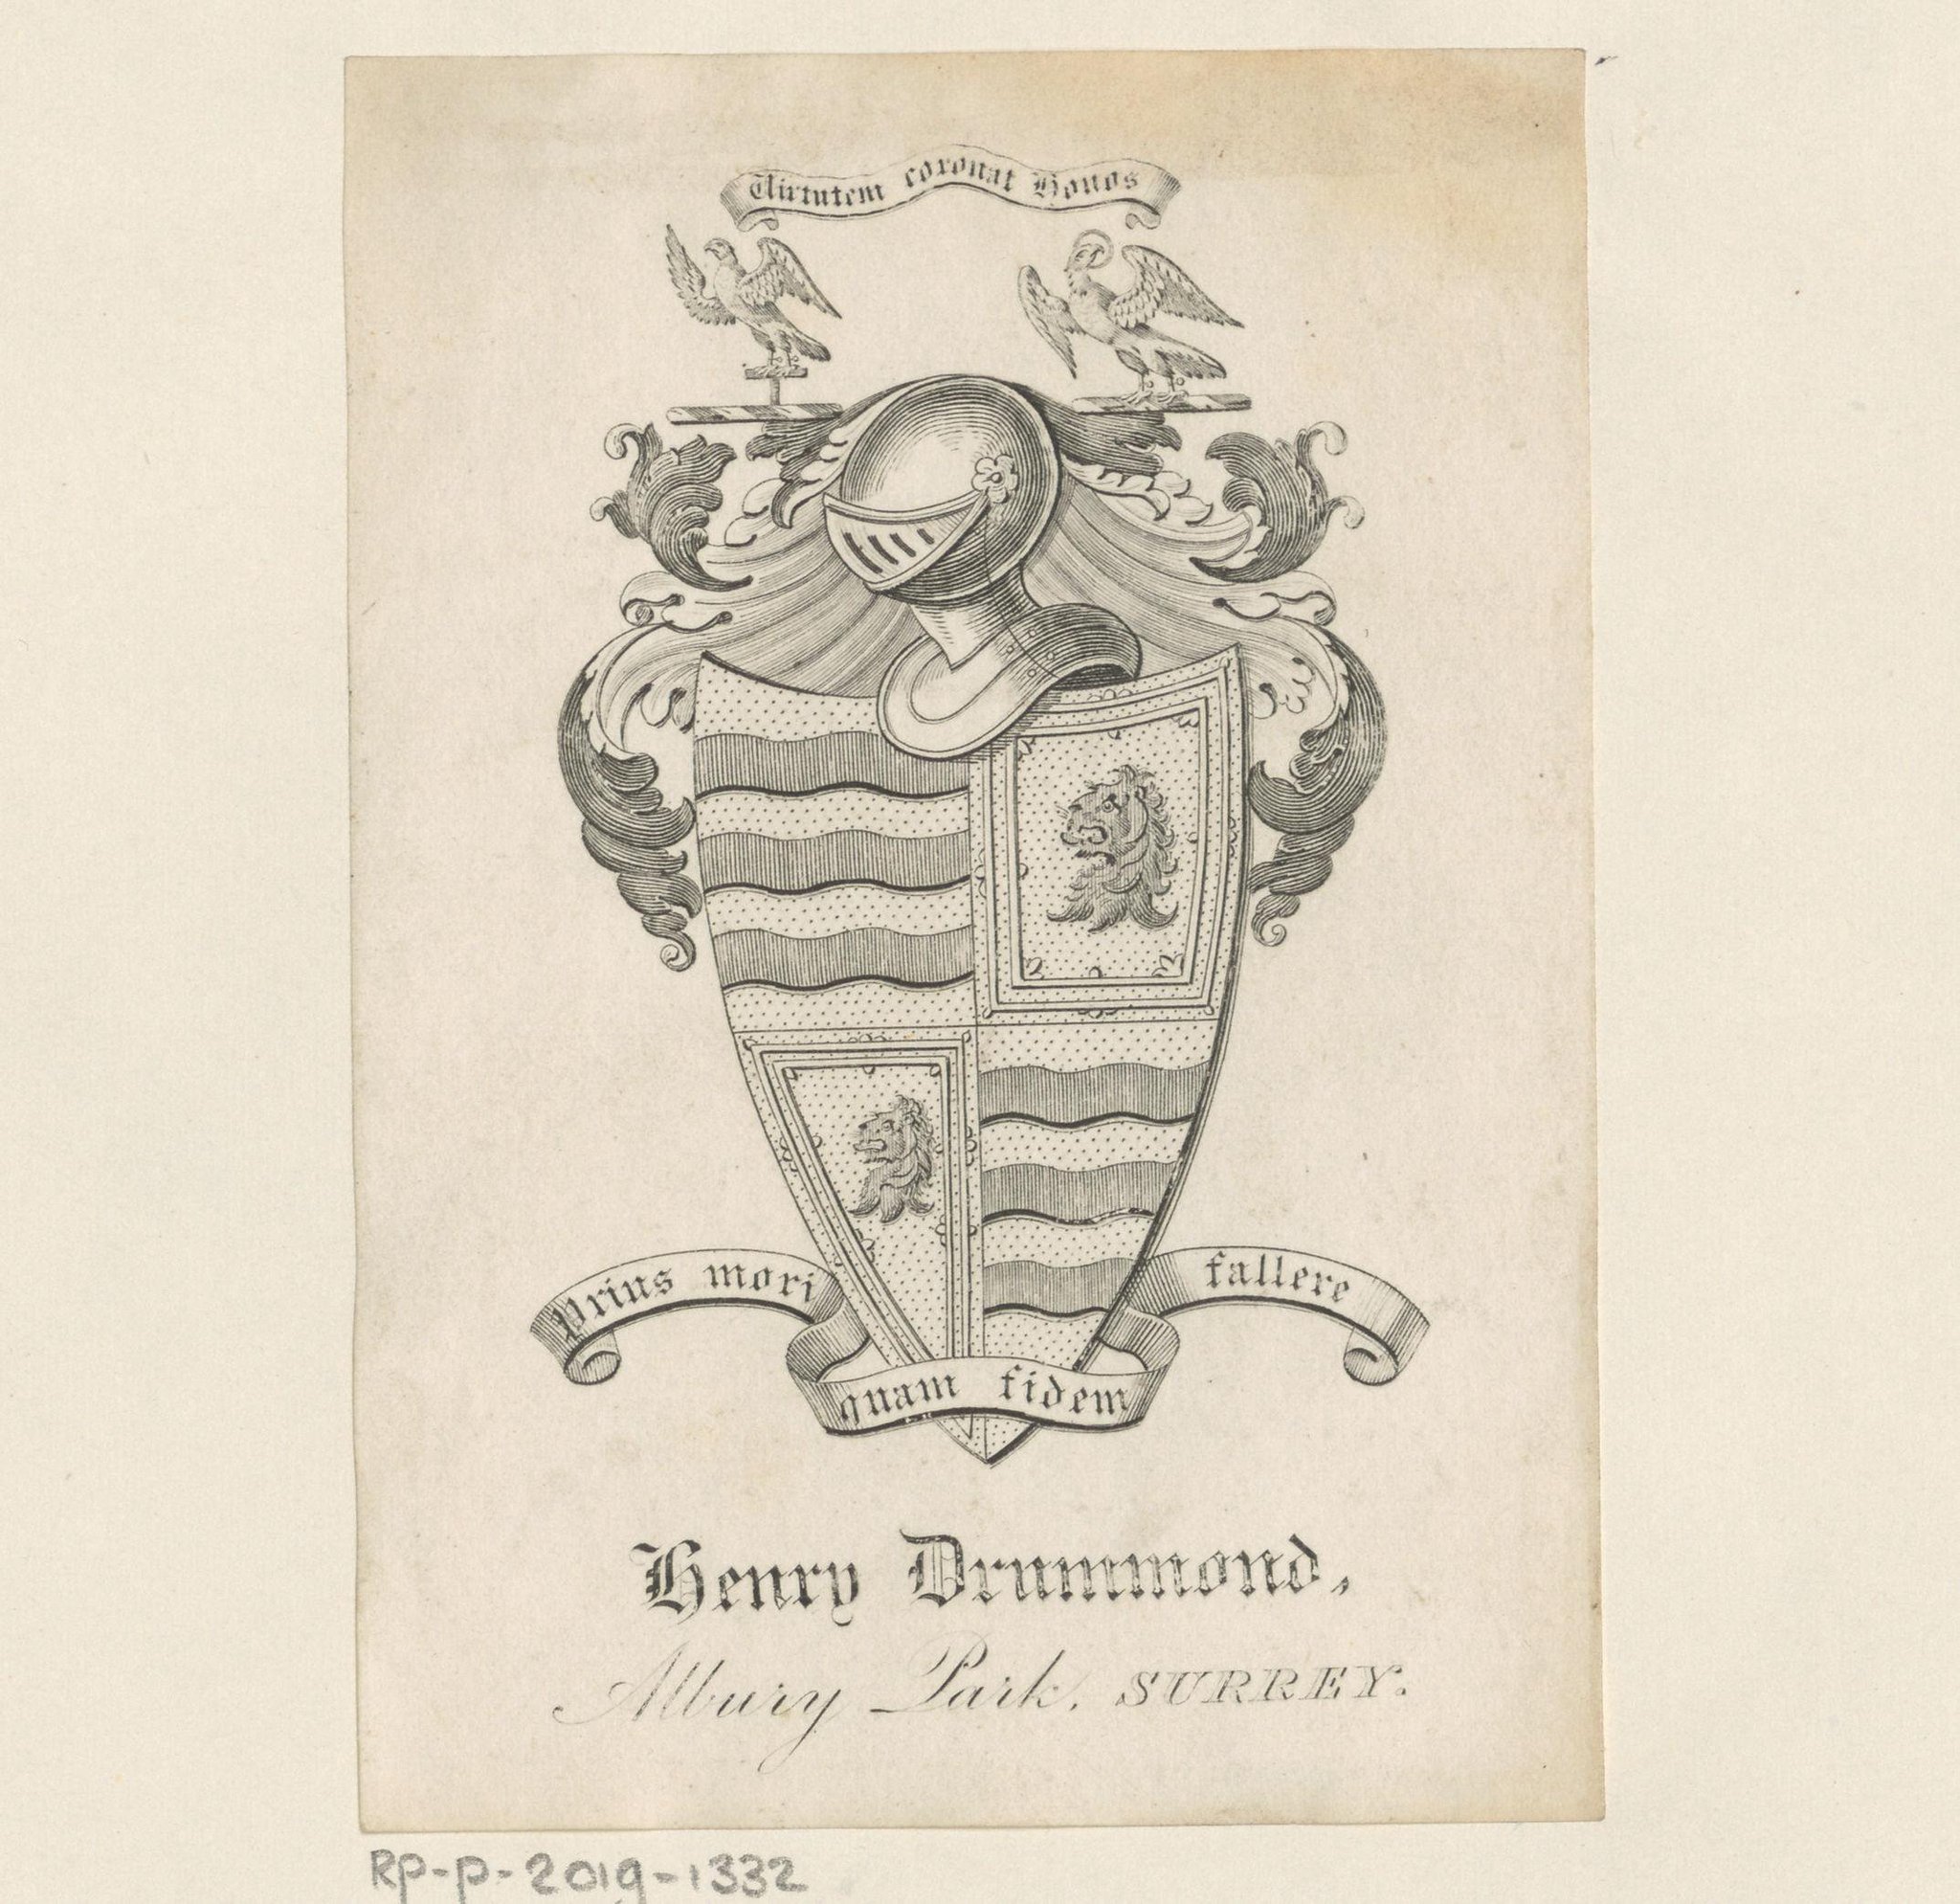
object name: bookplate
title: Ex libris van Henry Drummond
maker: Anonymous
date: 1861-1879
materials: paper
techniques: engraving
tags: armorial bearing, heraldry